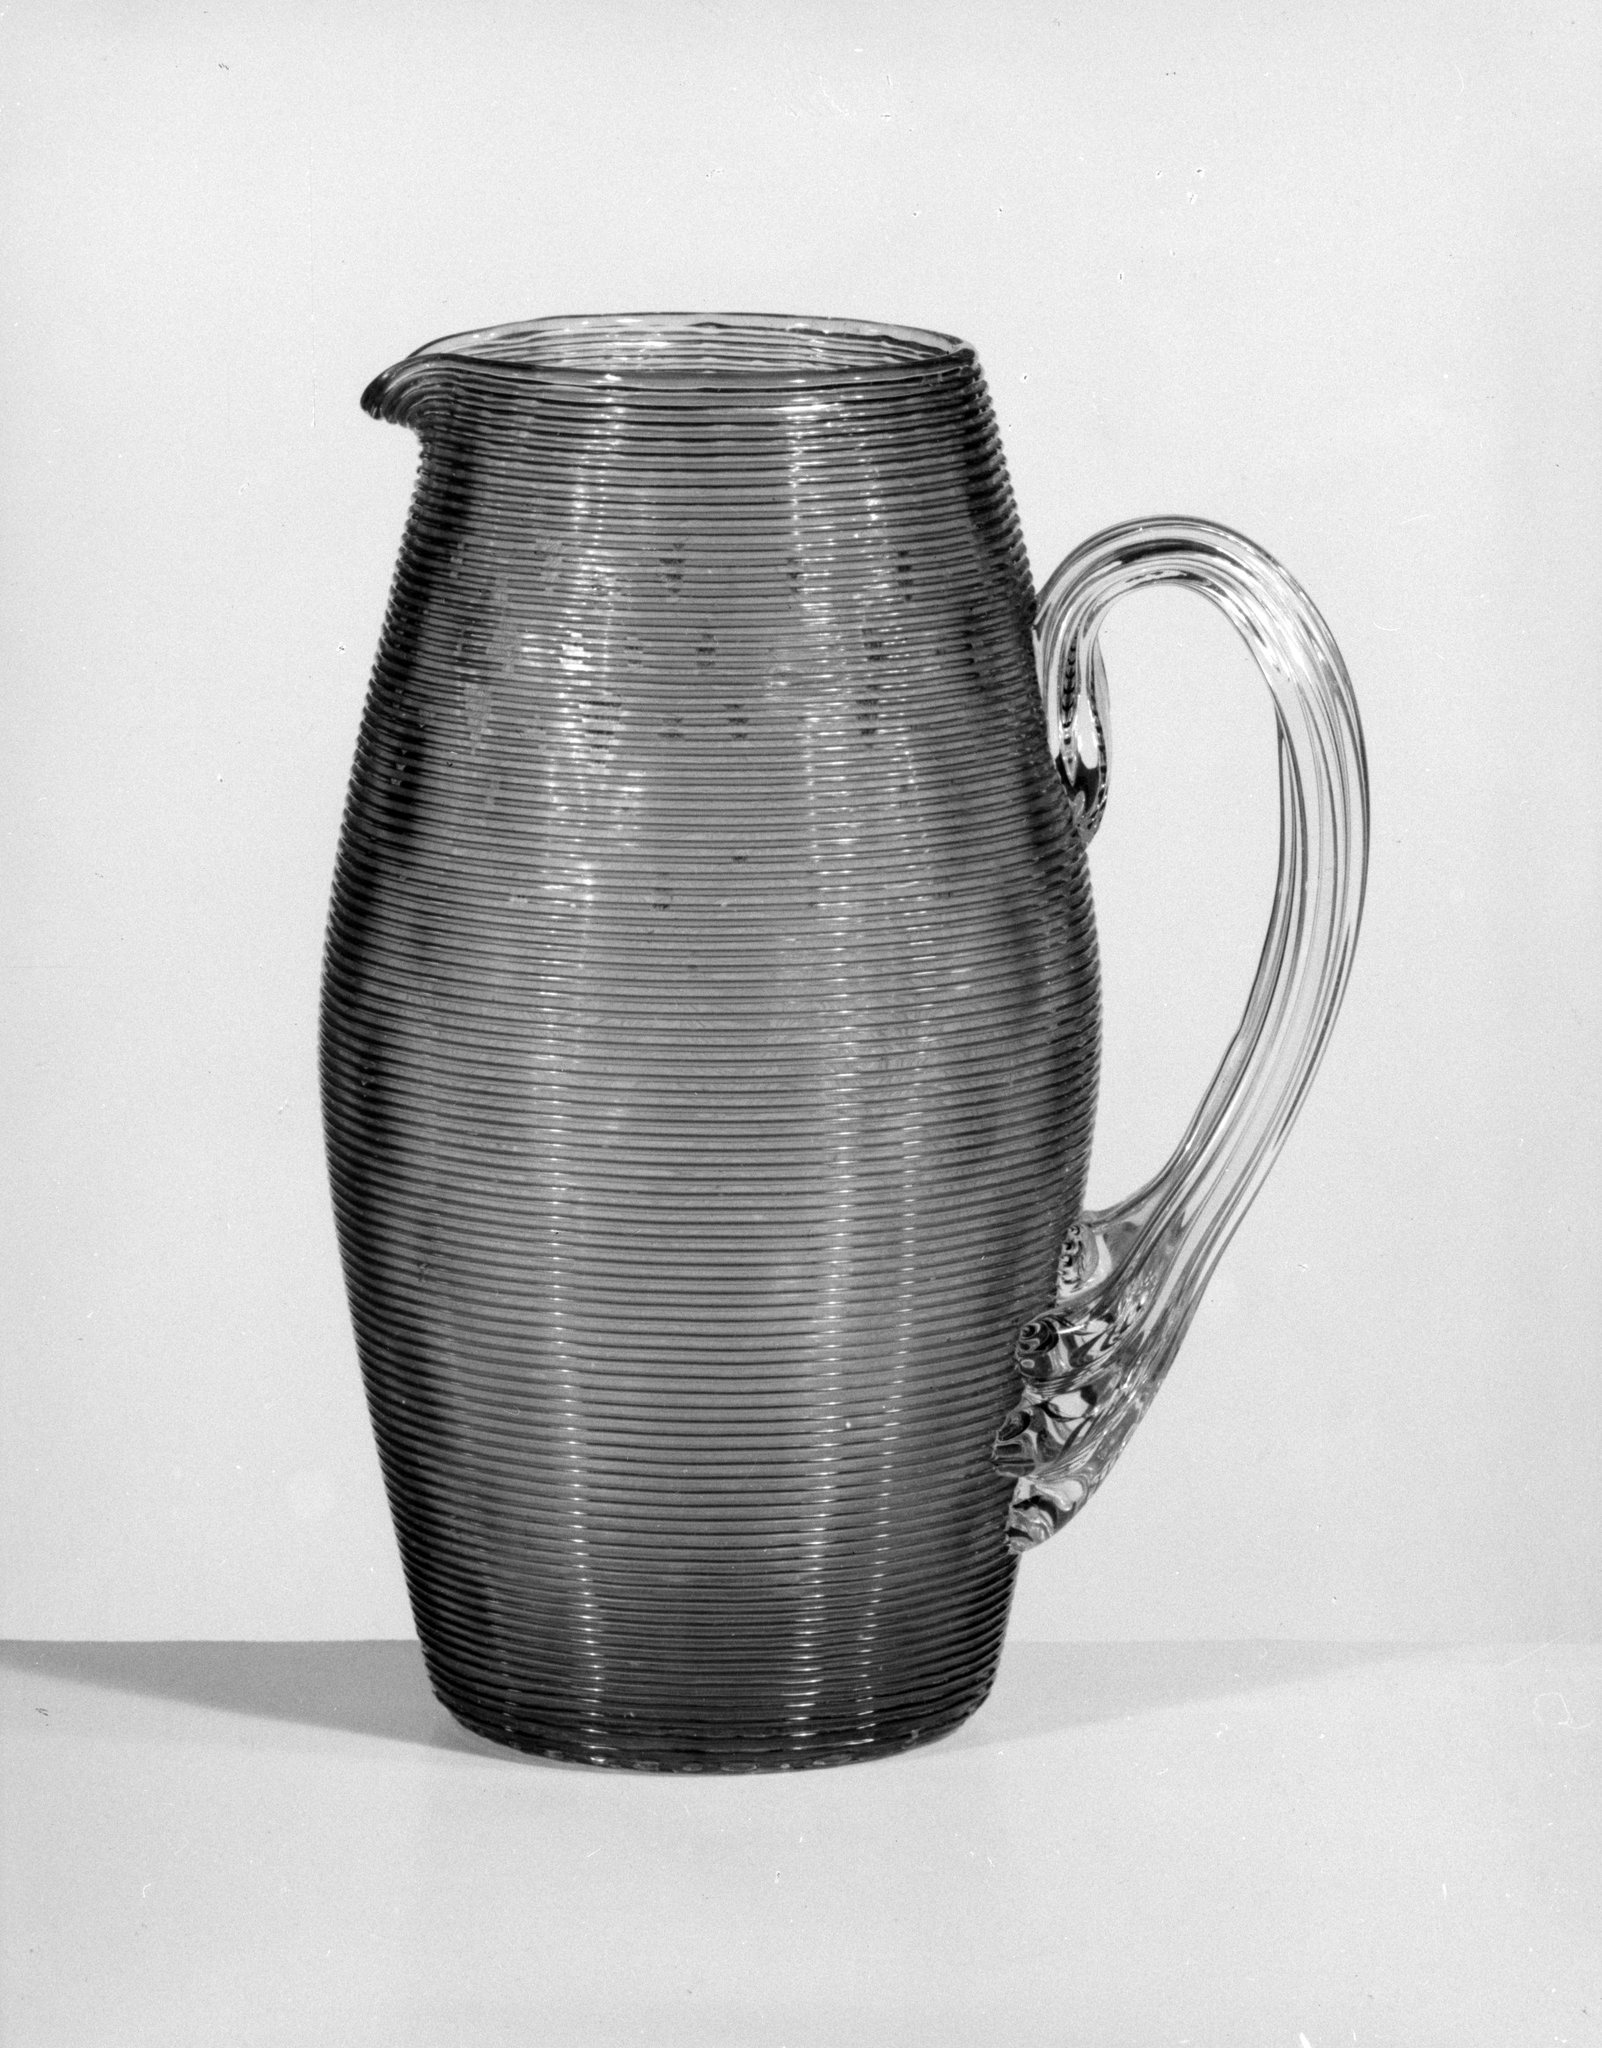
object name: pitcher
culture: american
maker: boston & sandwich glass company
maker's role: maker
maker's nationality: american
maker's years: 1825-1888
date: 1880-1888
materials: amber, glass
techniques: glassblowing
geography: united states